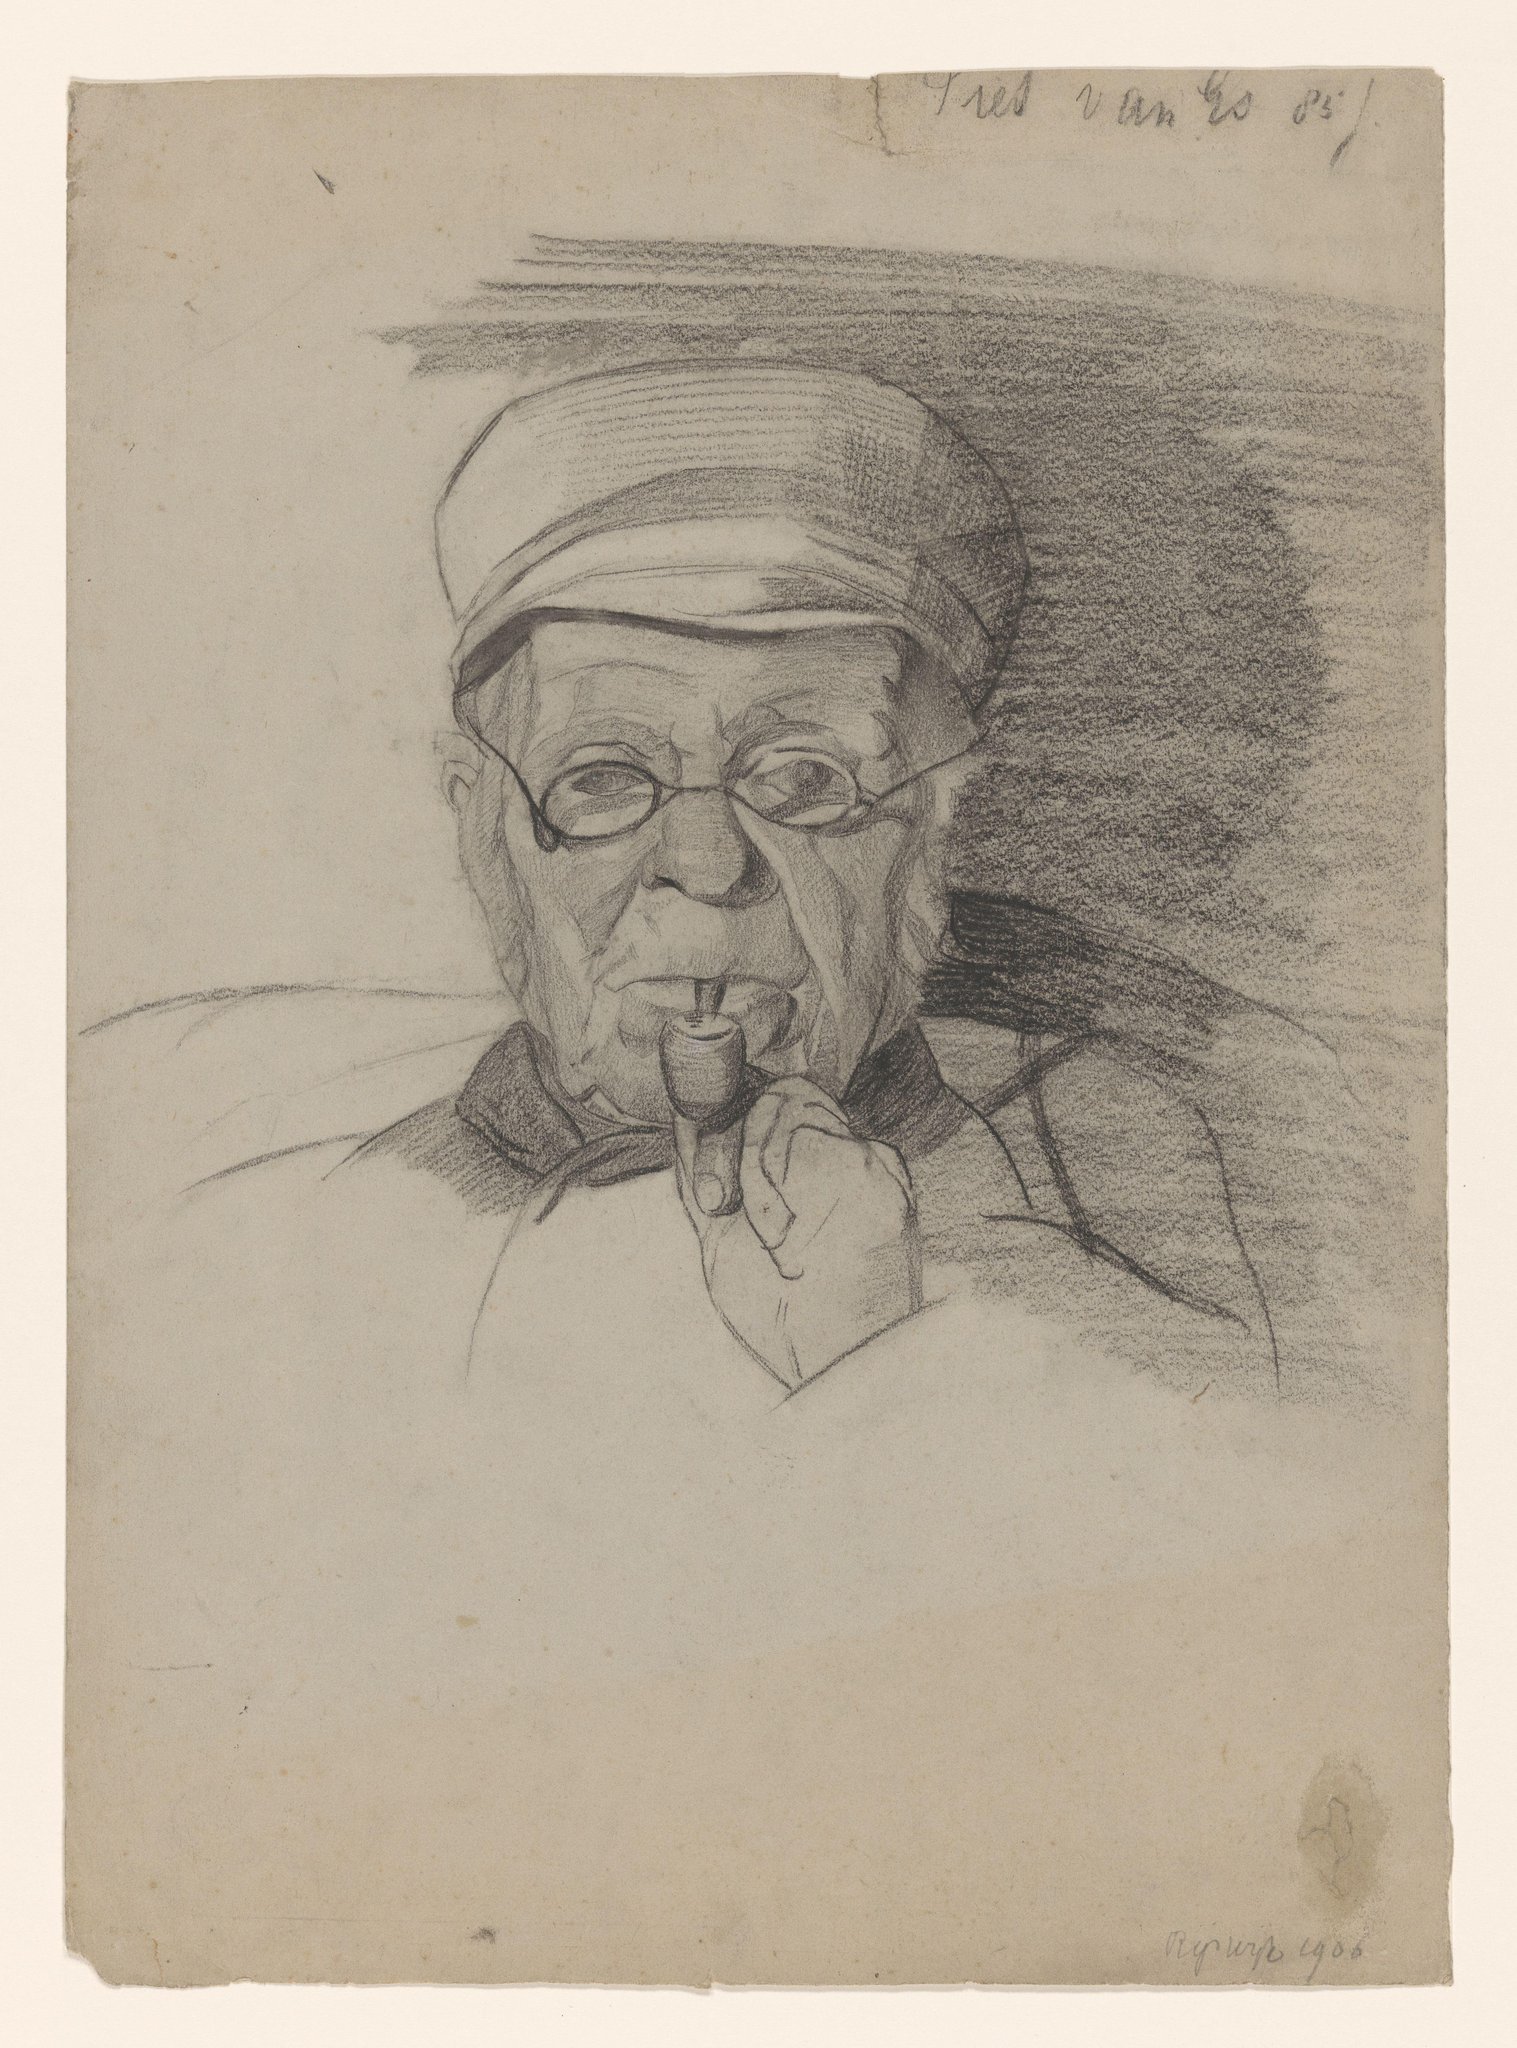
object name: drawing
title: Portret van een man met pet en pijp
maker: coba steenhoff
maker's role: draughtsman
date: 1906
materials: chalk, paper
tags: historical persons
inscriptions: date